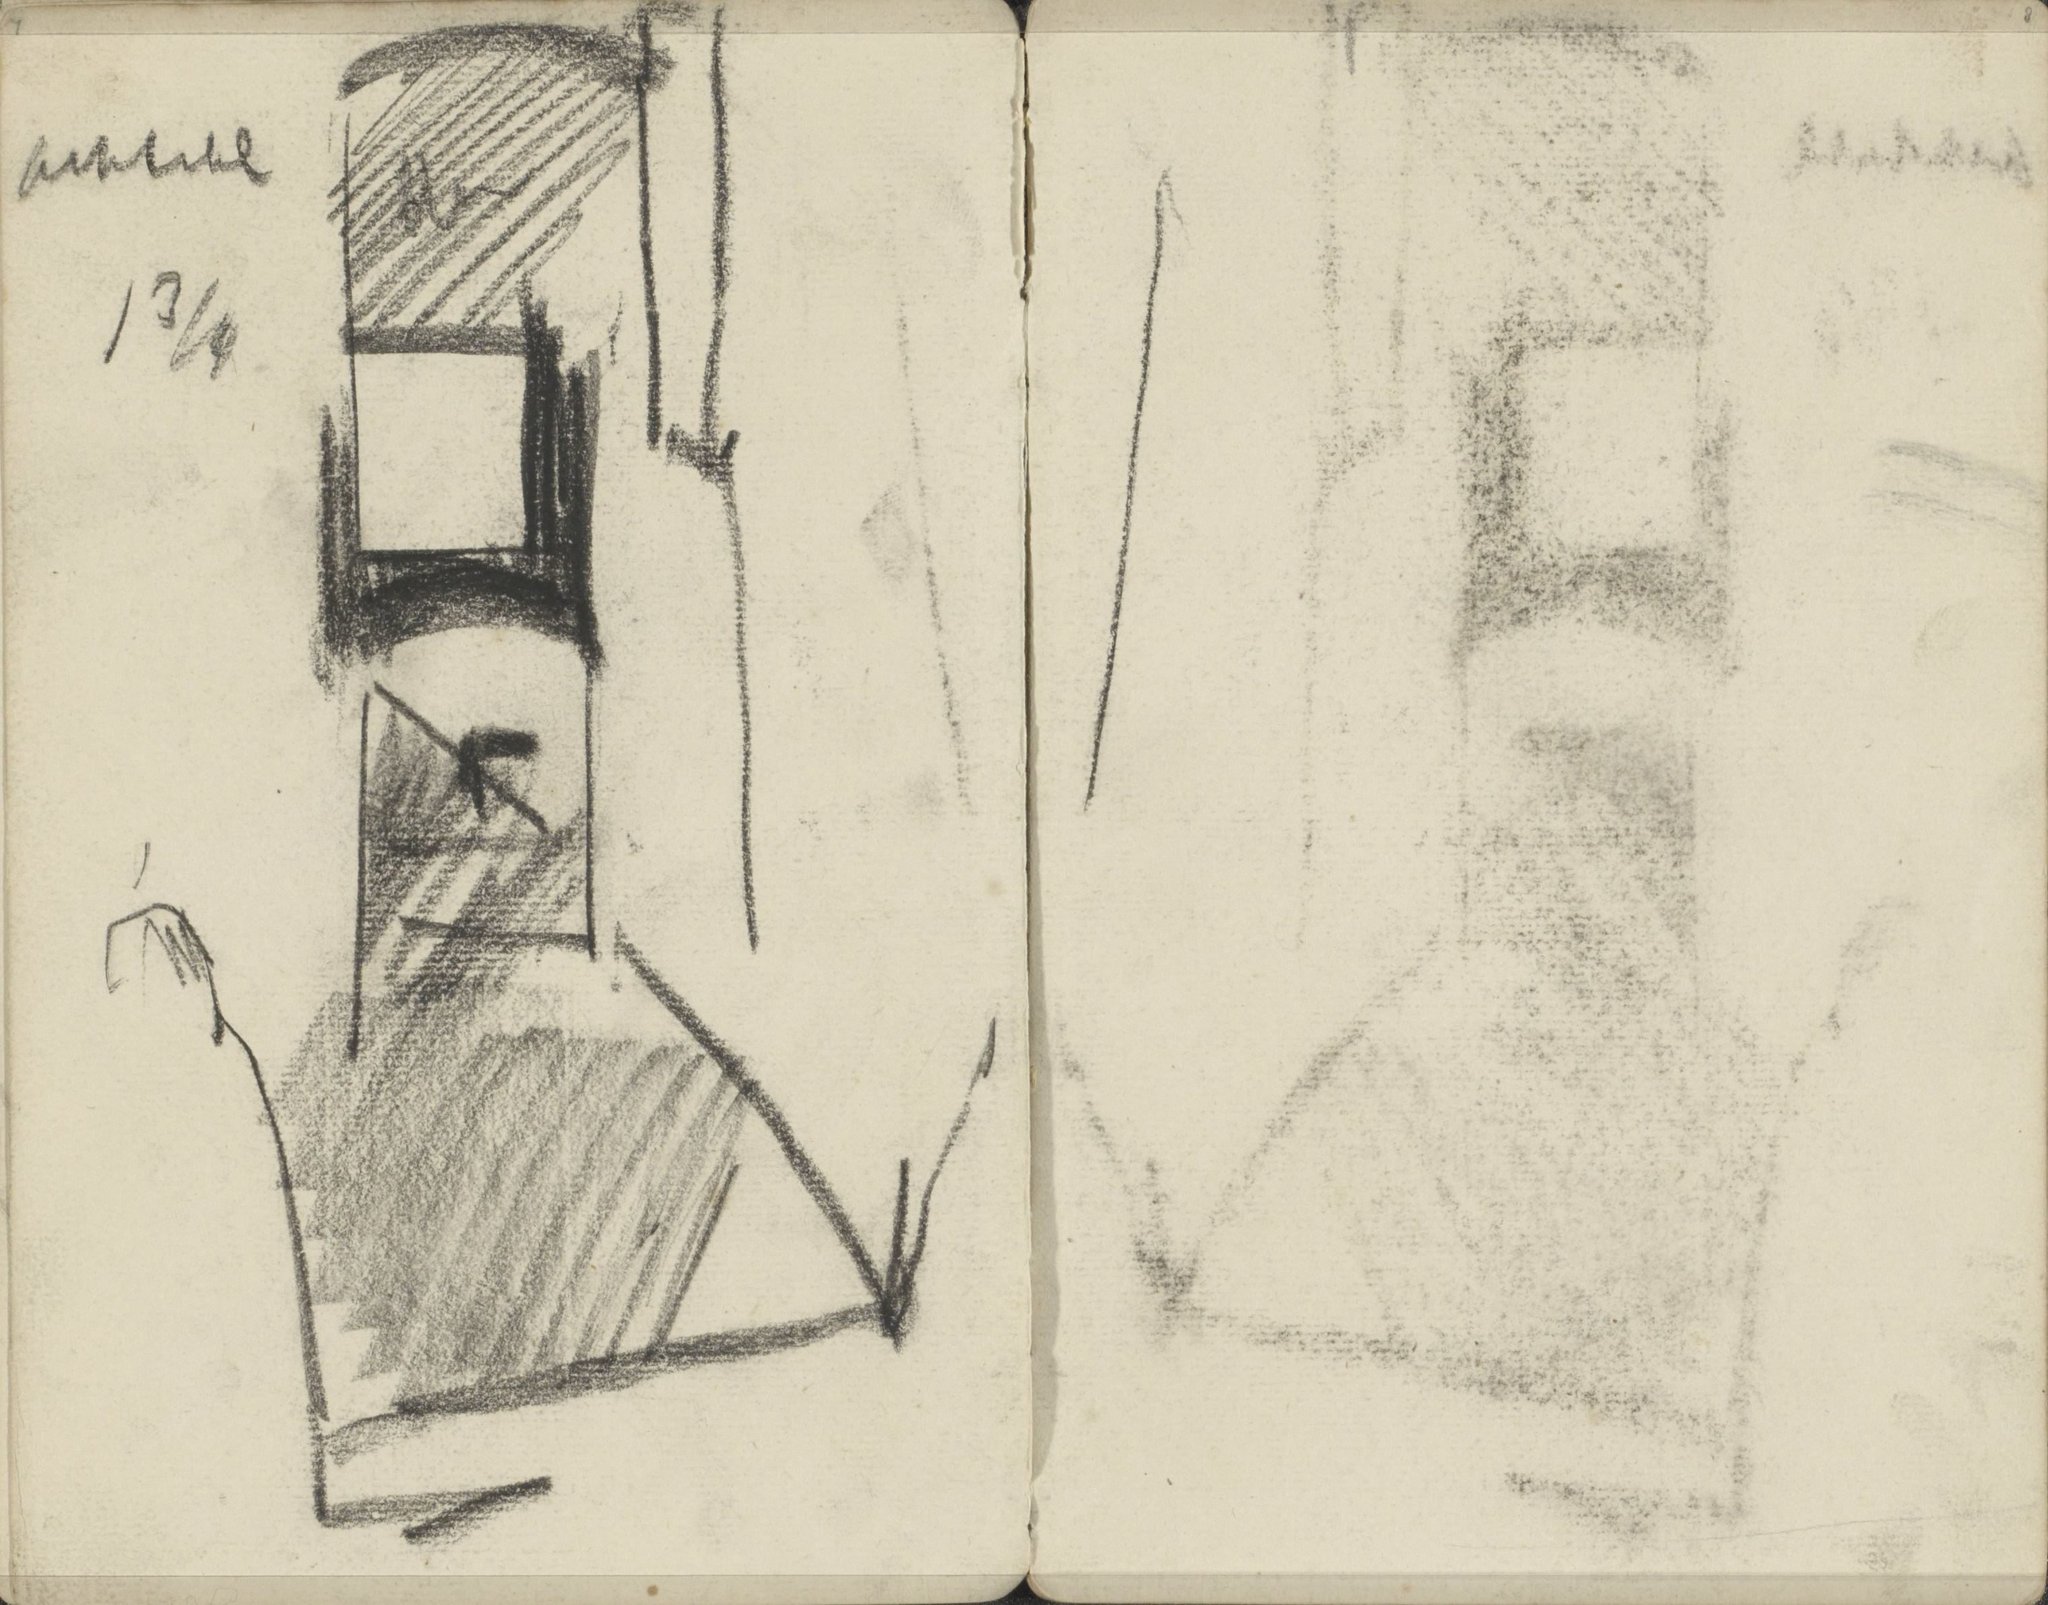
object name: sketchbook leaf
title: Studie, mogelijk van een poort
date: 1884-1886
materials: chalk, paper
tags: gate, entrance, lane, alley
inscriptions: annotation: ‘[...]/ 13/4’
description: Pagina 7 en pagina 8 uit een schetsboek met 16 bladen.